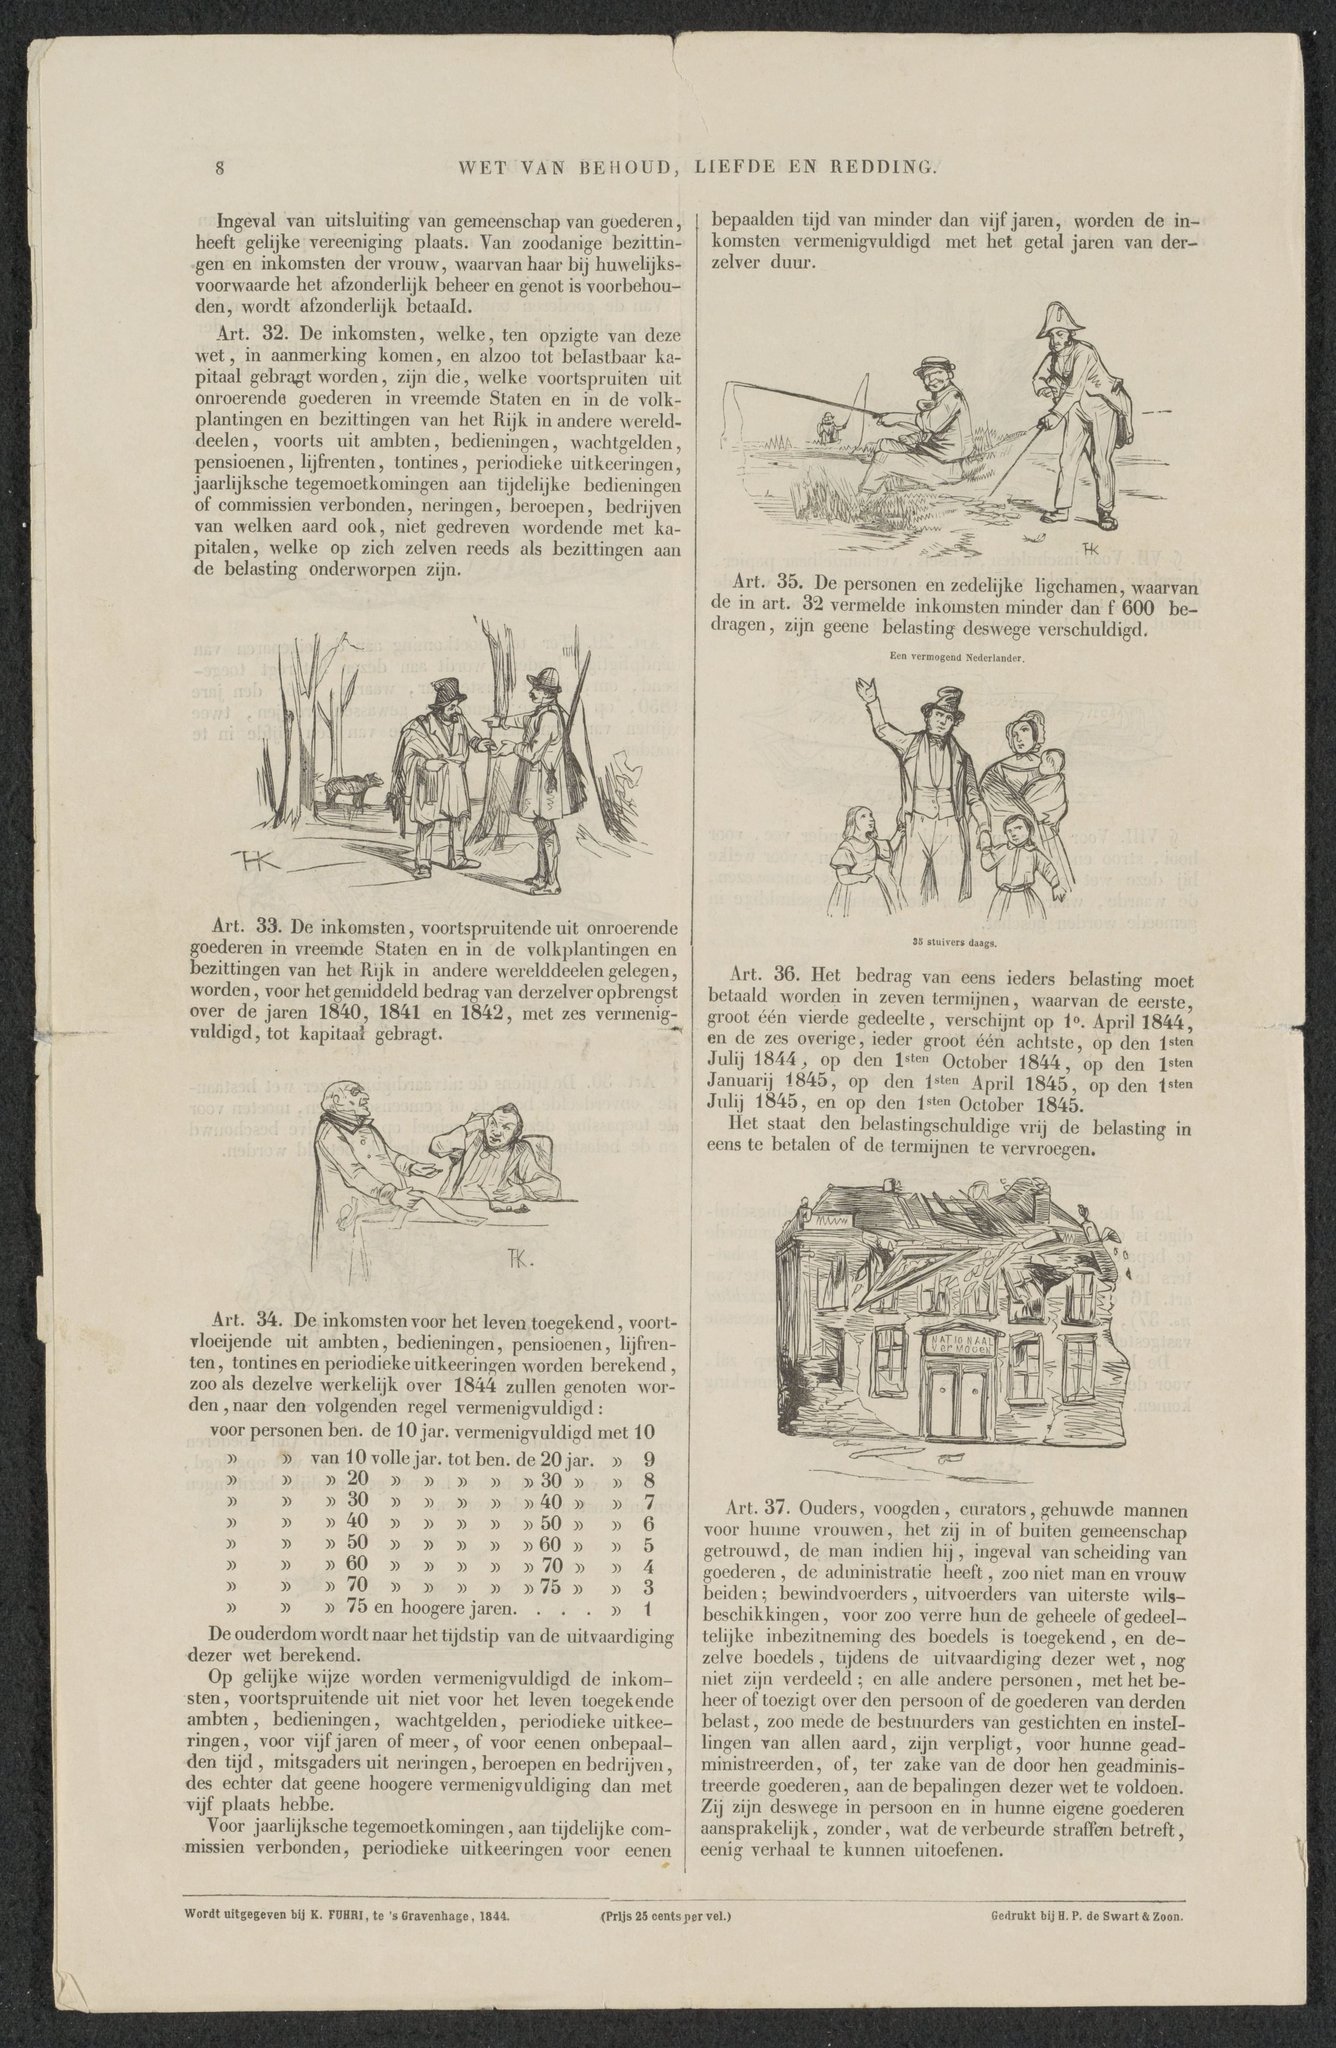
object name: print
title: Herdruk van de satire op de aansporing tot deelneming in de (zogenaamde) vrijwillige 3% geldlening van 1844 (blad 8)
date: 1844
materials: paper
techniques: letterpress printing, engraving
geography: the hague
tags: the hague, floris adriaan van hall, organization of trade and finance, taxes and financial administration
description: Bladzijde 8 met artikels 32-37 van het 'Vermeerderd, Verbeterd en de Volmaaktheid Overtreffend Nieuw Ontwerp van Wet van Behoud, Liefde en Redding'. Een enigszins aaangepaste herdruk van satire in zestien bladzijden op de aansporing tot deelneming in de (zogenaamde) vrijwillige 3% geldlening uitgeschreven in maart 1844 door minister F.A. van Hall. Achterzijde van een dubbelgevouwen blad bedrukt op alle zijden.